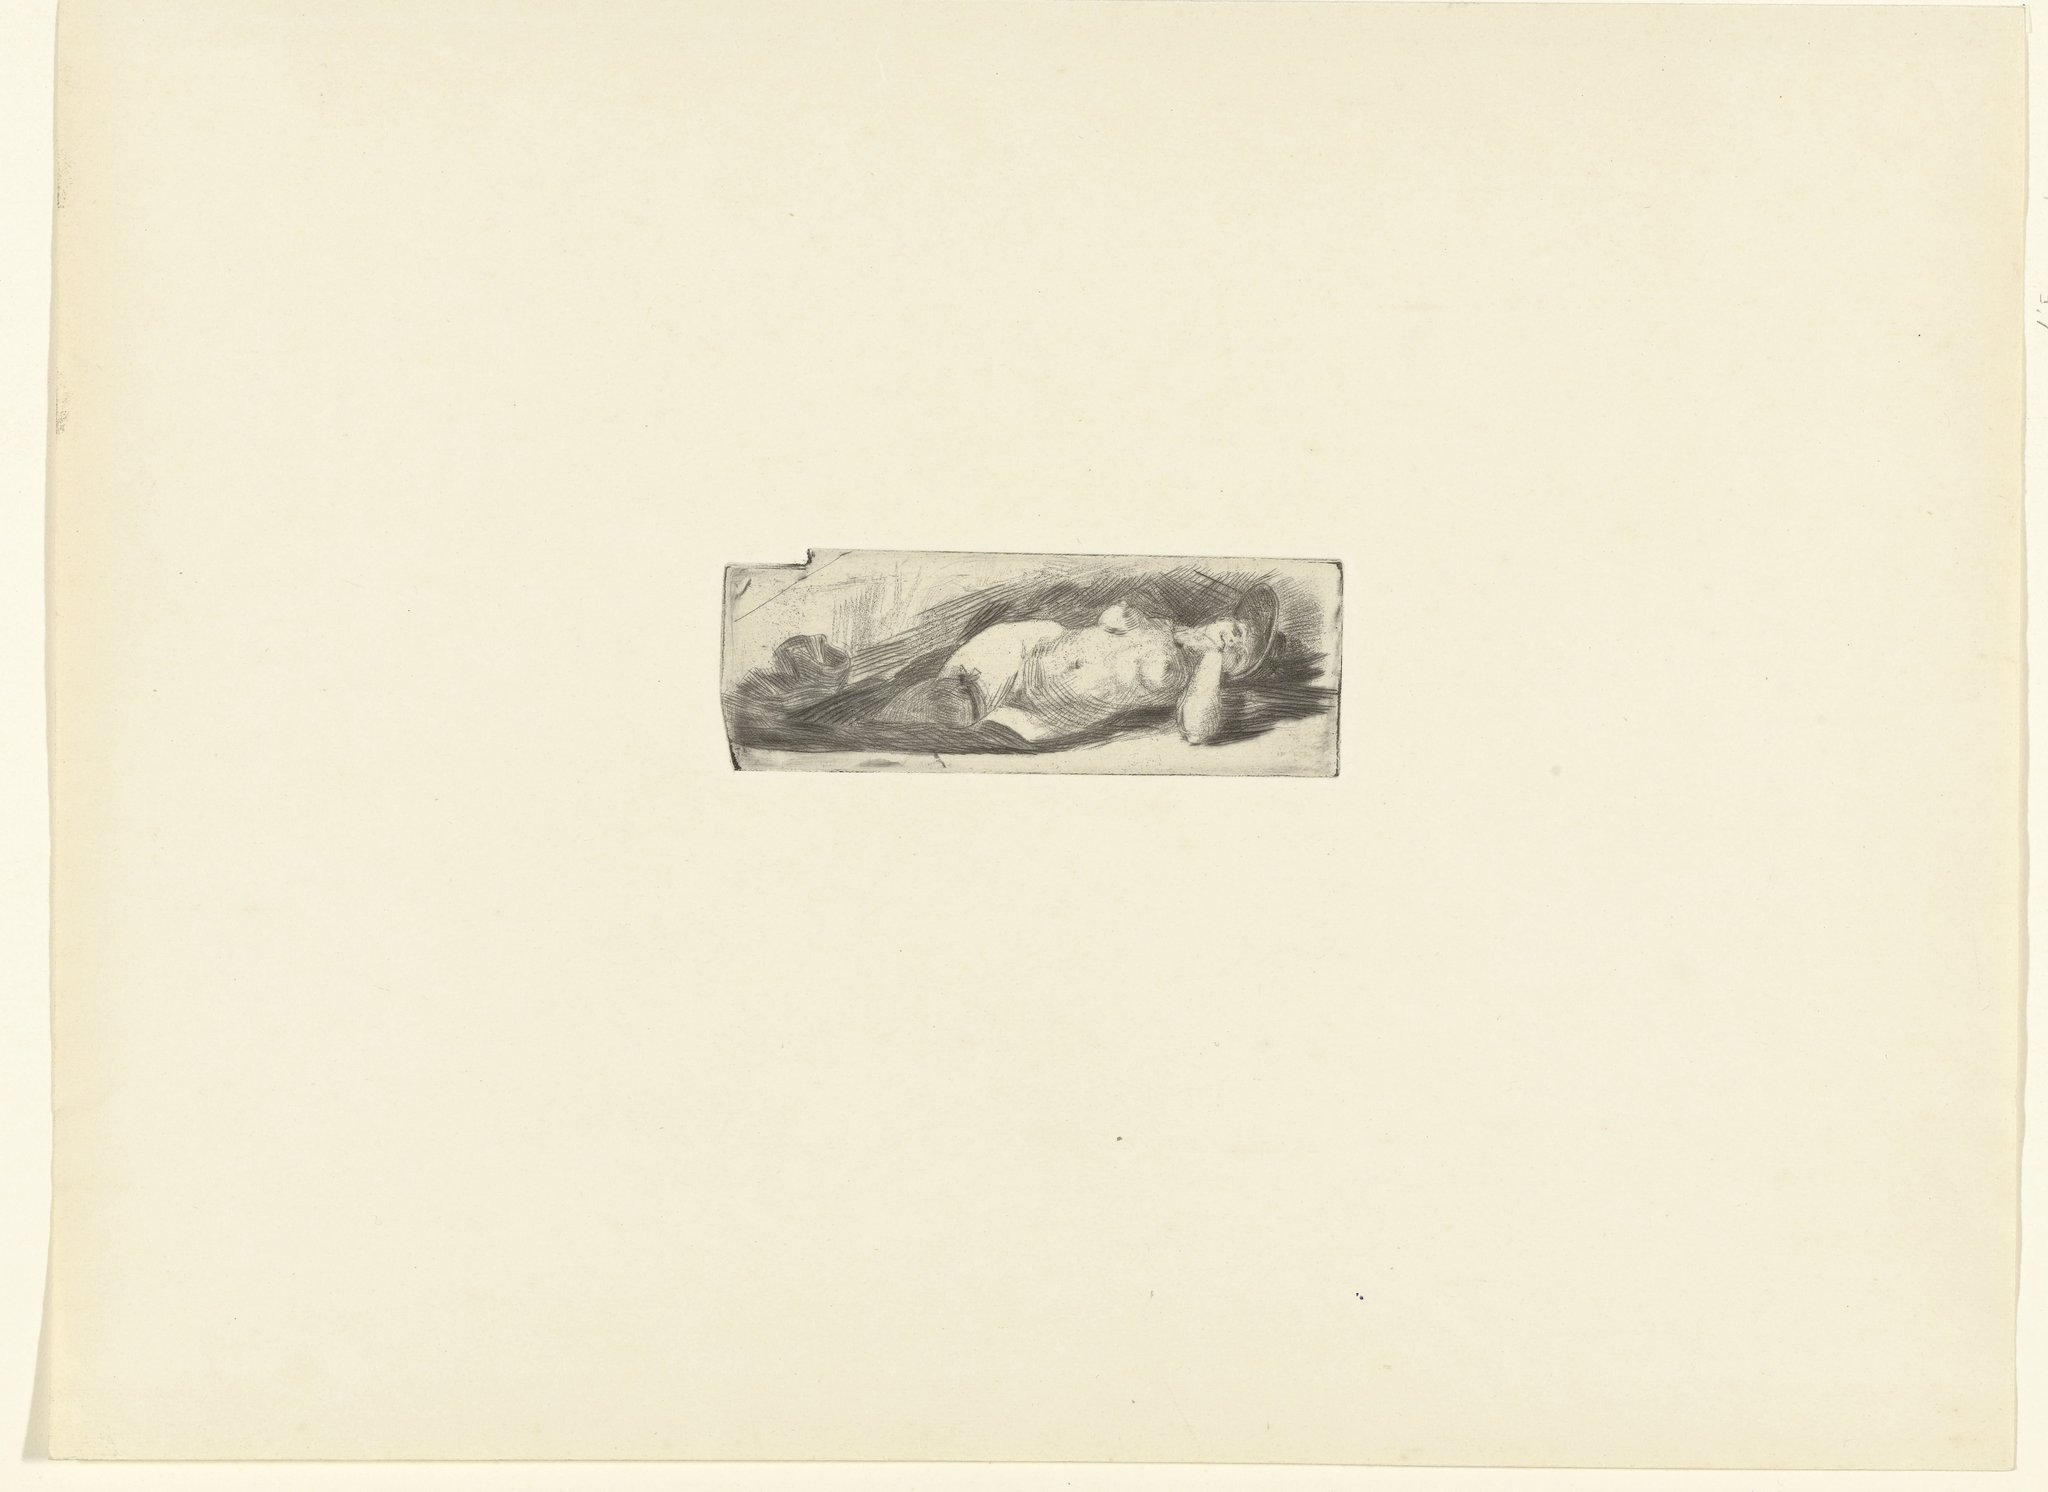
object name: print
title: L'Epreuve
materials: paper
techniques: drypoint, soft ground etching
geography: france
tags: the (nude) human figure; 'corpo humano' (ripa), female sex; woman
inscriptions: collector's mark: Lugt 2760, collector's mark: Lugt 2228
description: Verschenen in album met tien originele prenten bij tijdschrift: L'Epreuve, februari 1895, prent nr. 4